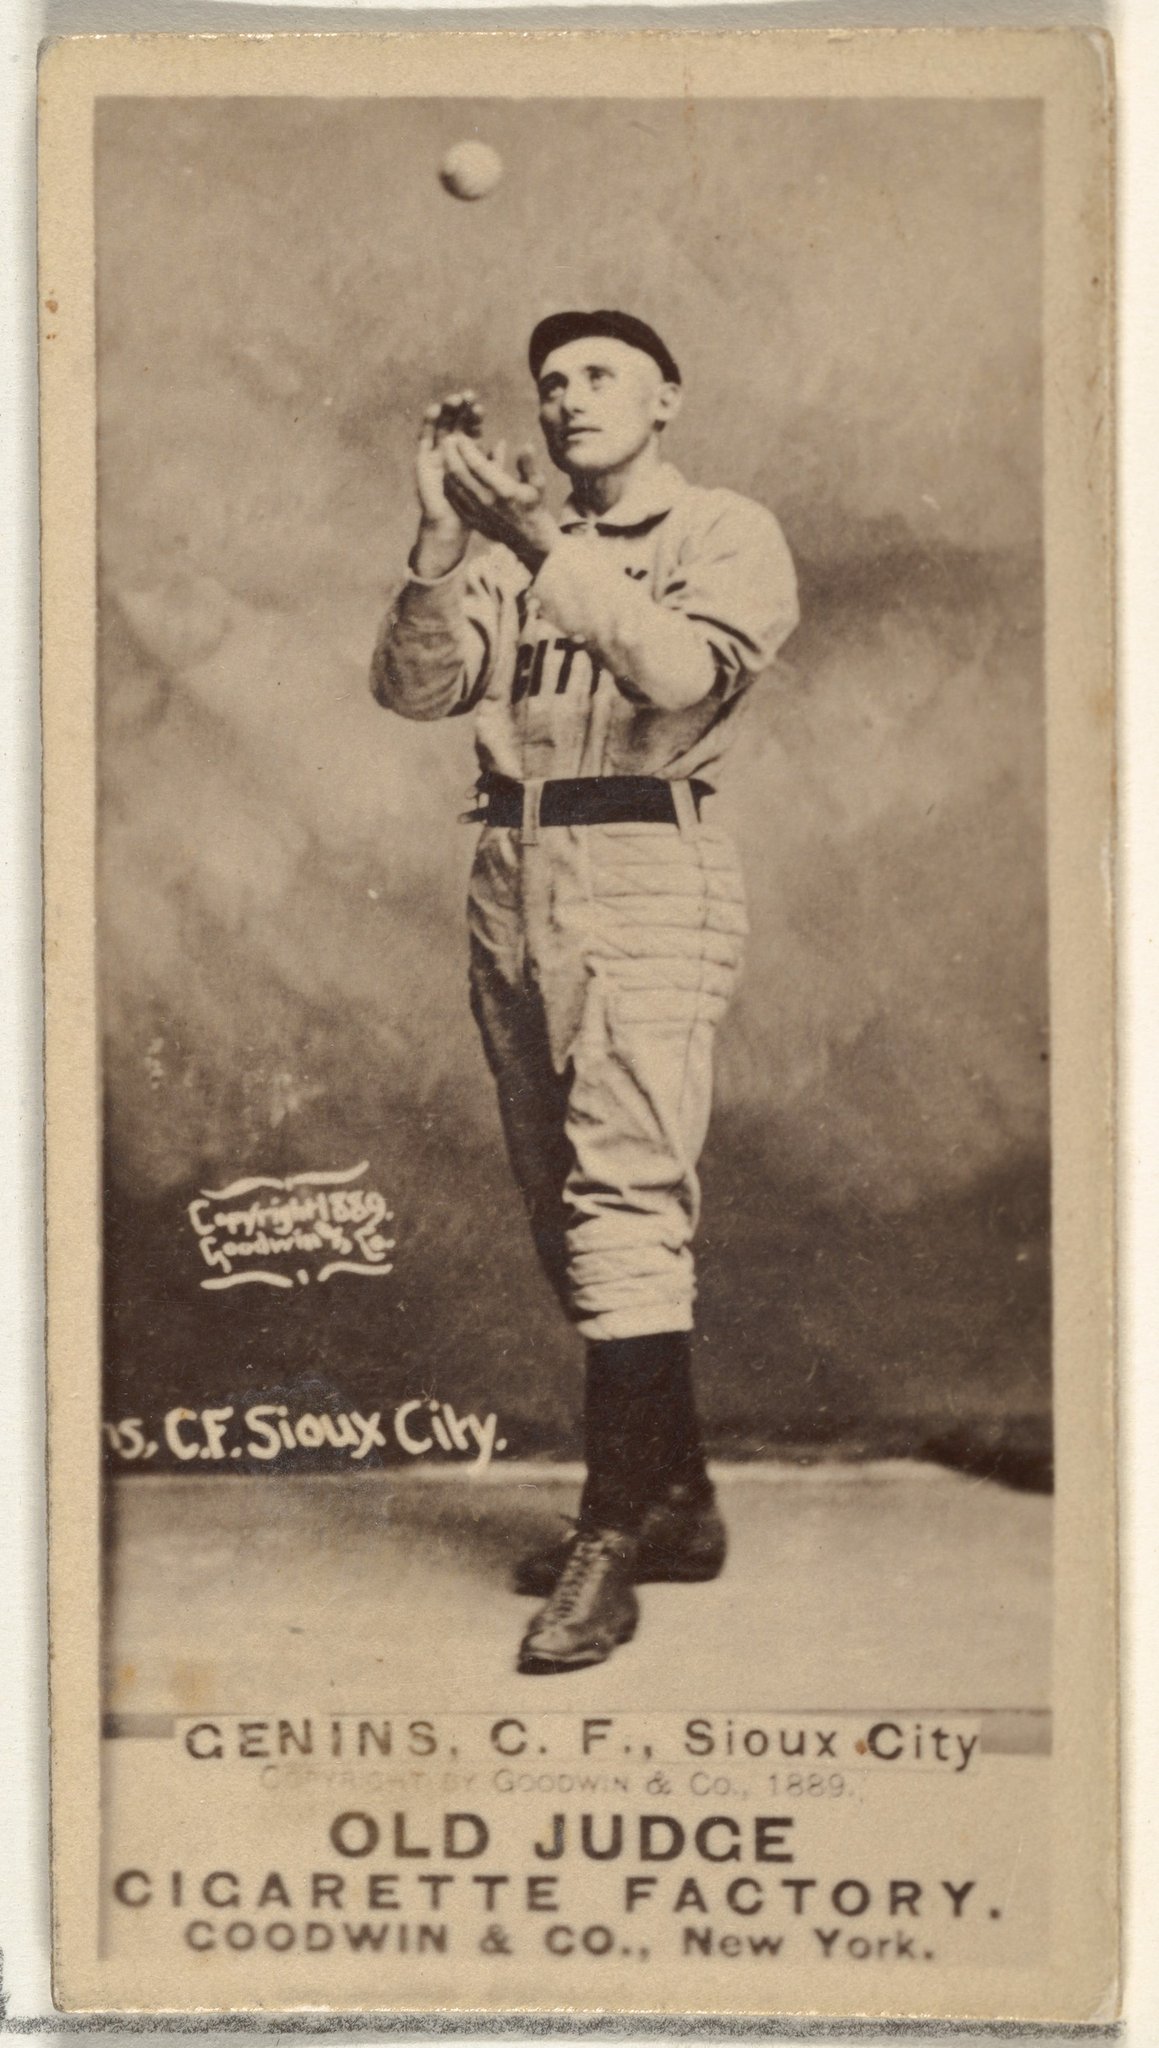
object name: baseball card, photograph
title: C. Frank Genins, Center Field, Sioux City Corn Huskers, from the Old Judge series (N172) for Old Judge Cigarettes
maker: goodwin & company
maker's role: publisher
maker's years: 1850-1950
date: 1889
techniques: albumen silver print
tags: men,portraits,baseball,athletes